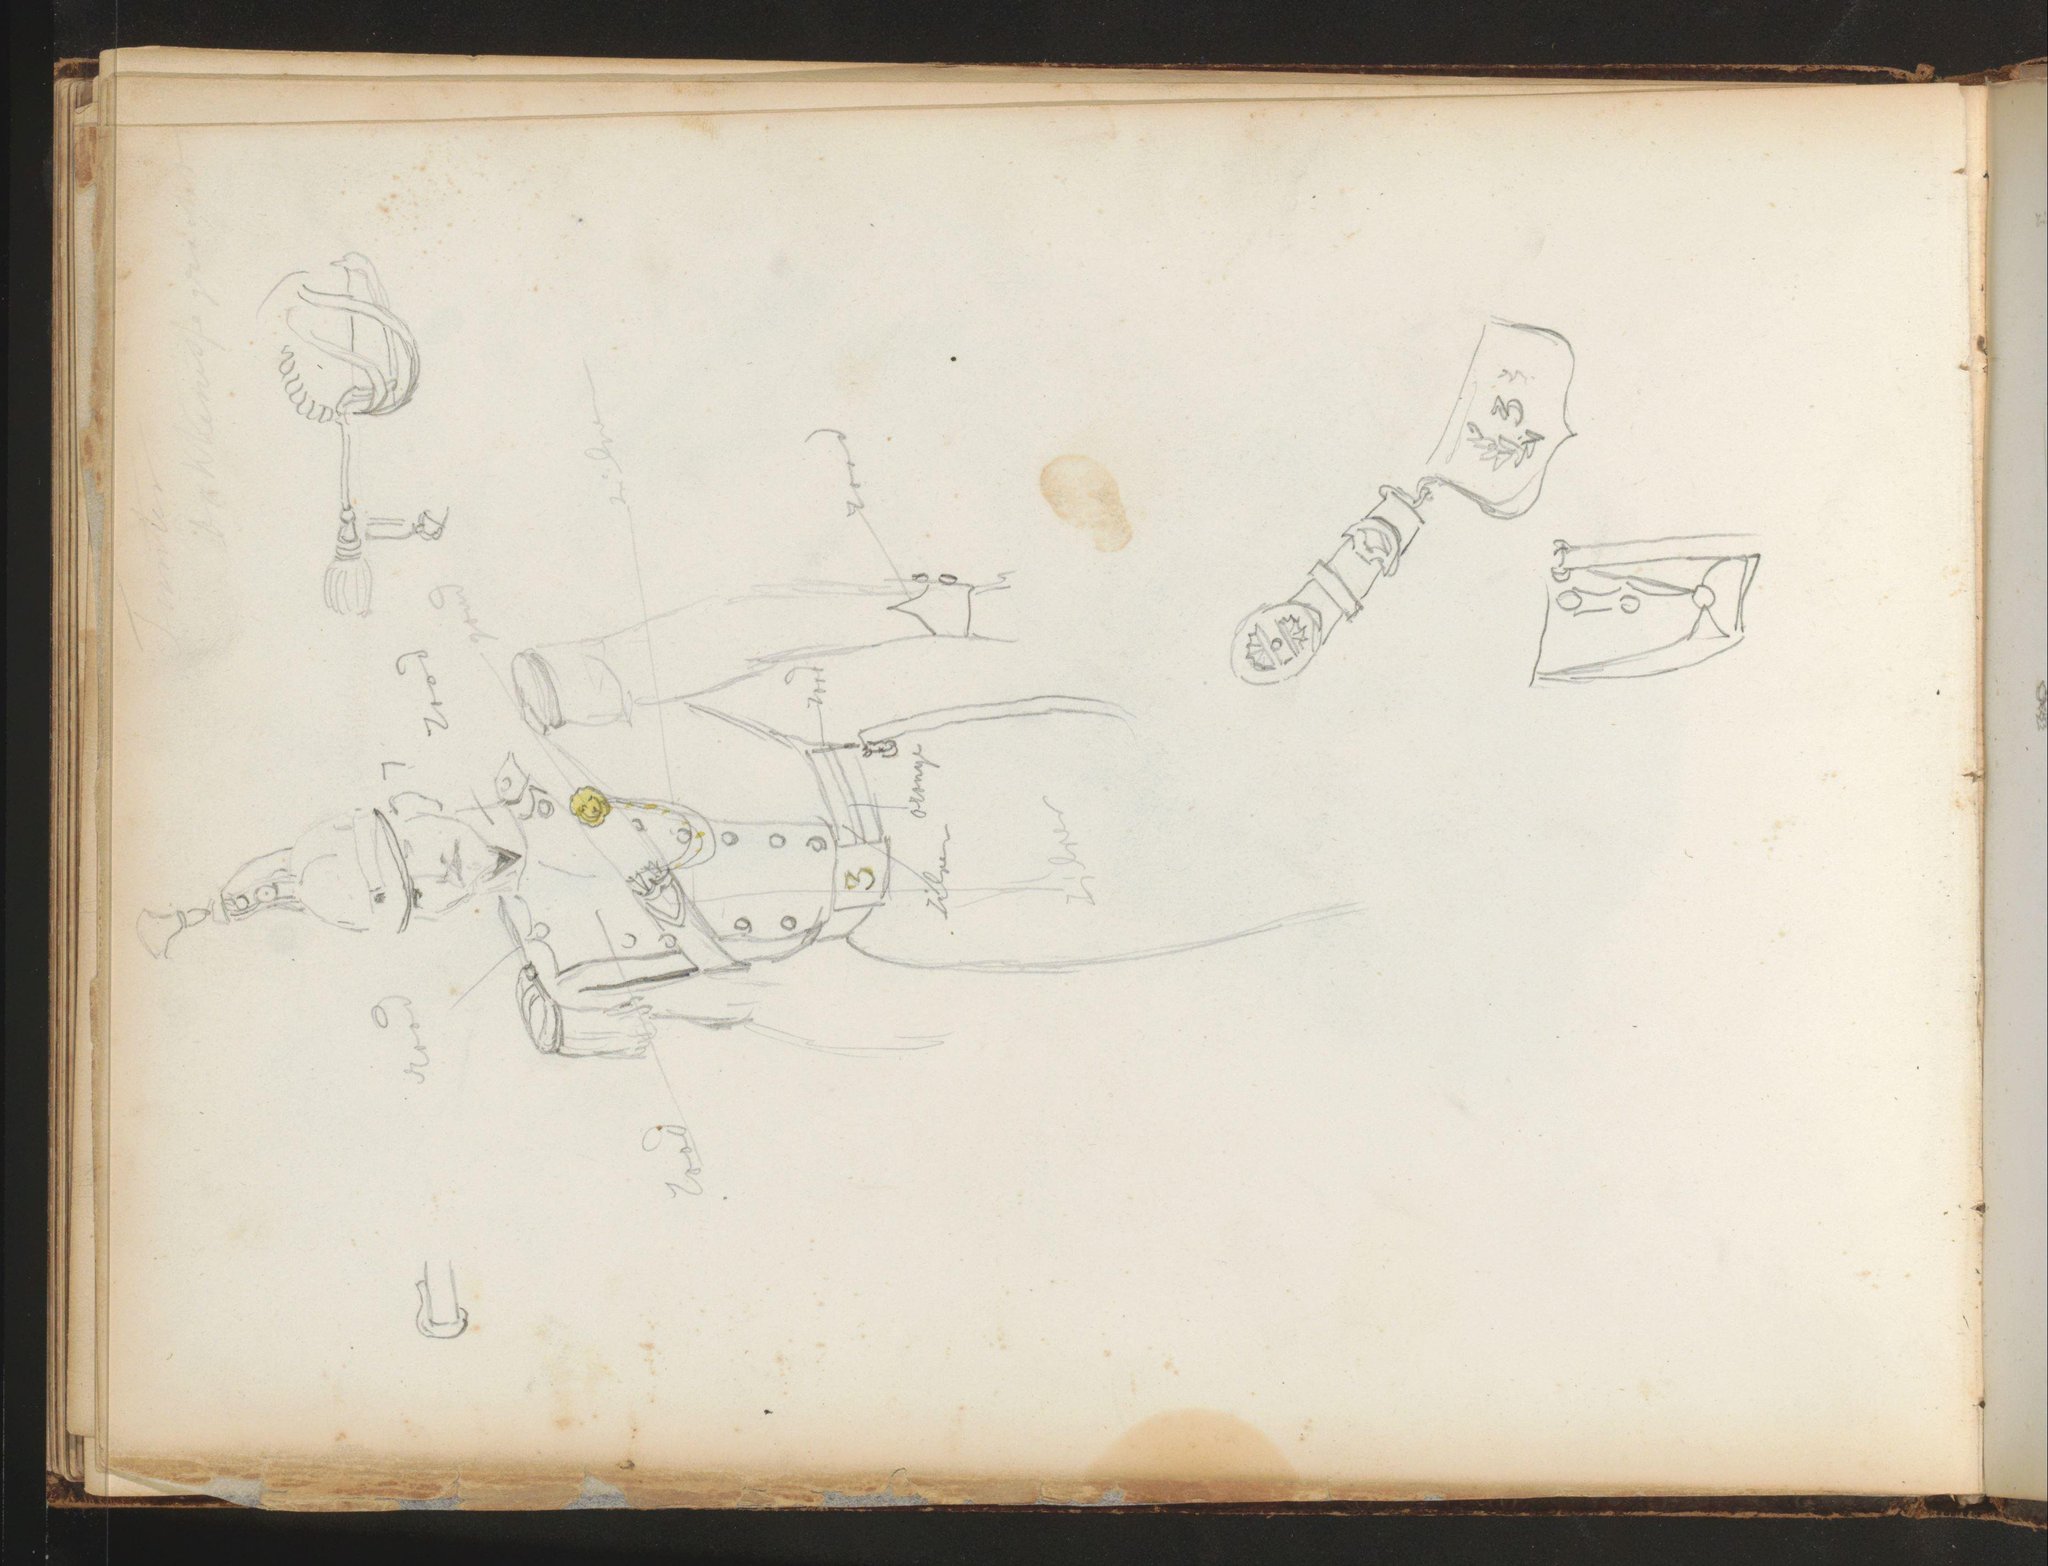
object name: sketchbook leaf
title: Soldaat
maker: reinier craeyvanger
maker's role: draughtsman, print maker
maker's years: 1812-1880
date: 1822-1880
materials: paper, pencil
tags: military clothing and other equipment (uniforms, cap, armour, helmet, etc.)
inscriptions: annotation: ‘Ti[...]ter/ bakkenesegracht’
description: De man draagt een militaire uitrusting, waaronder een jas met epauletten en helm. Tevens studies van details van het kostuum. Blad 37 verso uit een schetsboek met 45 bladen.